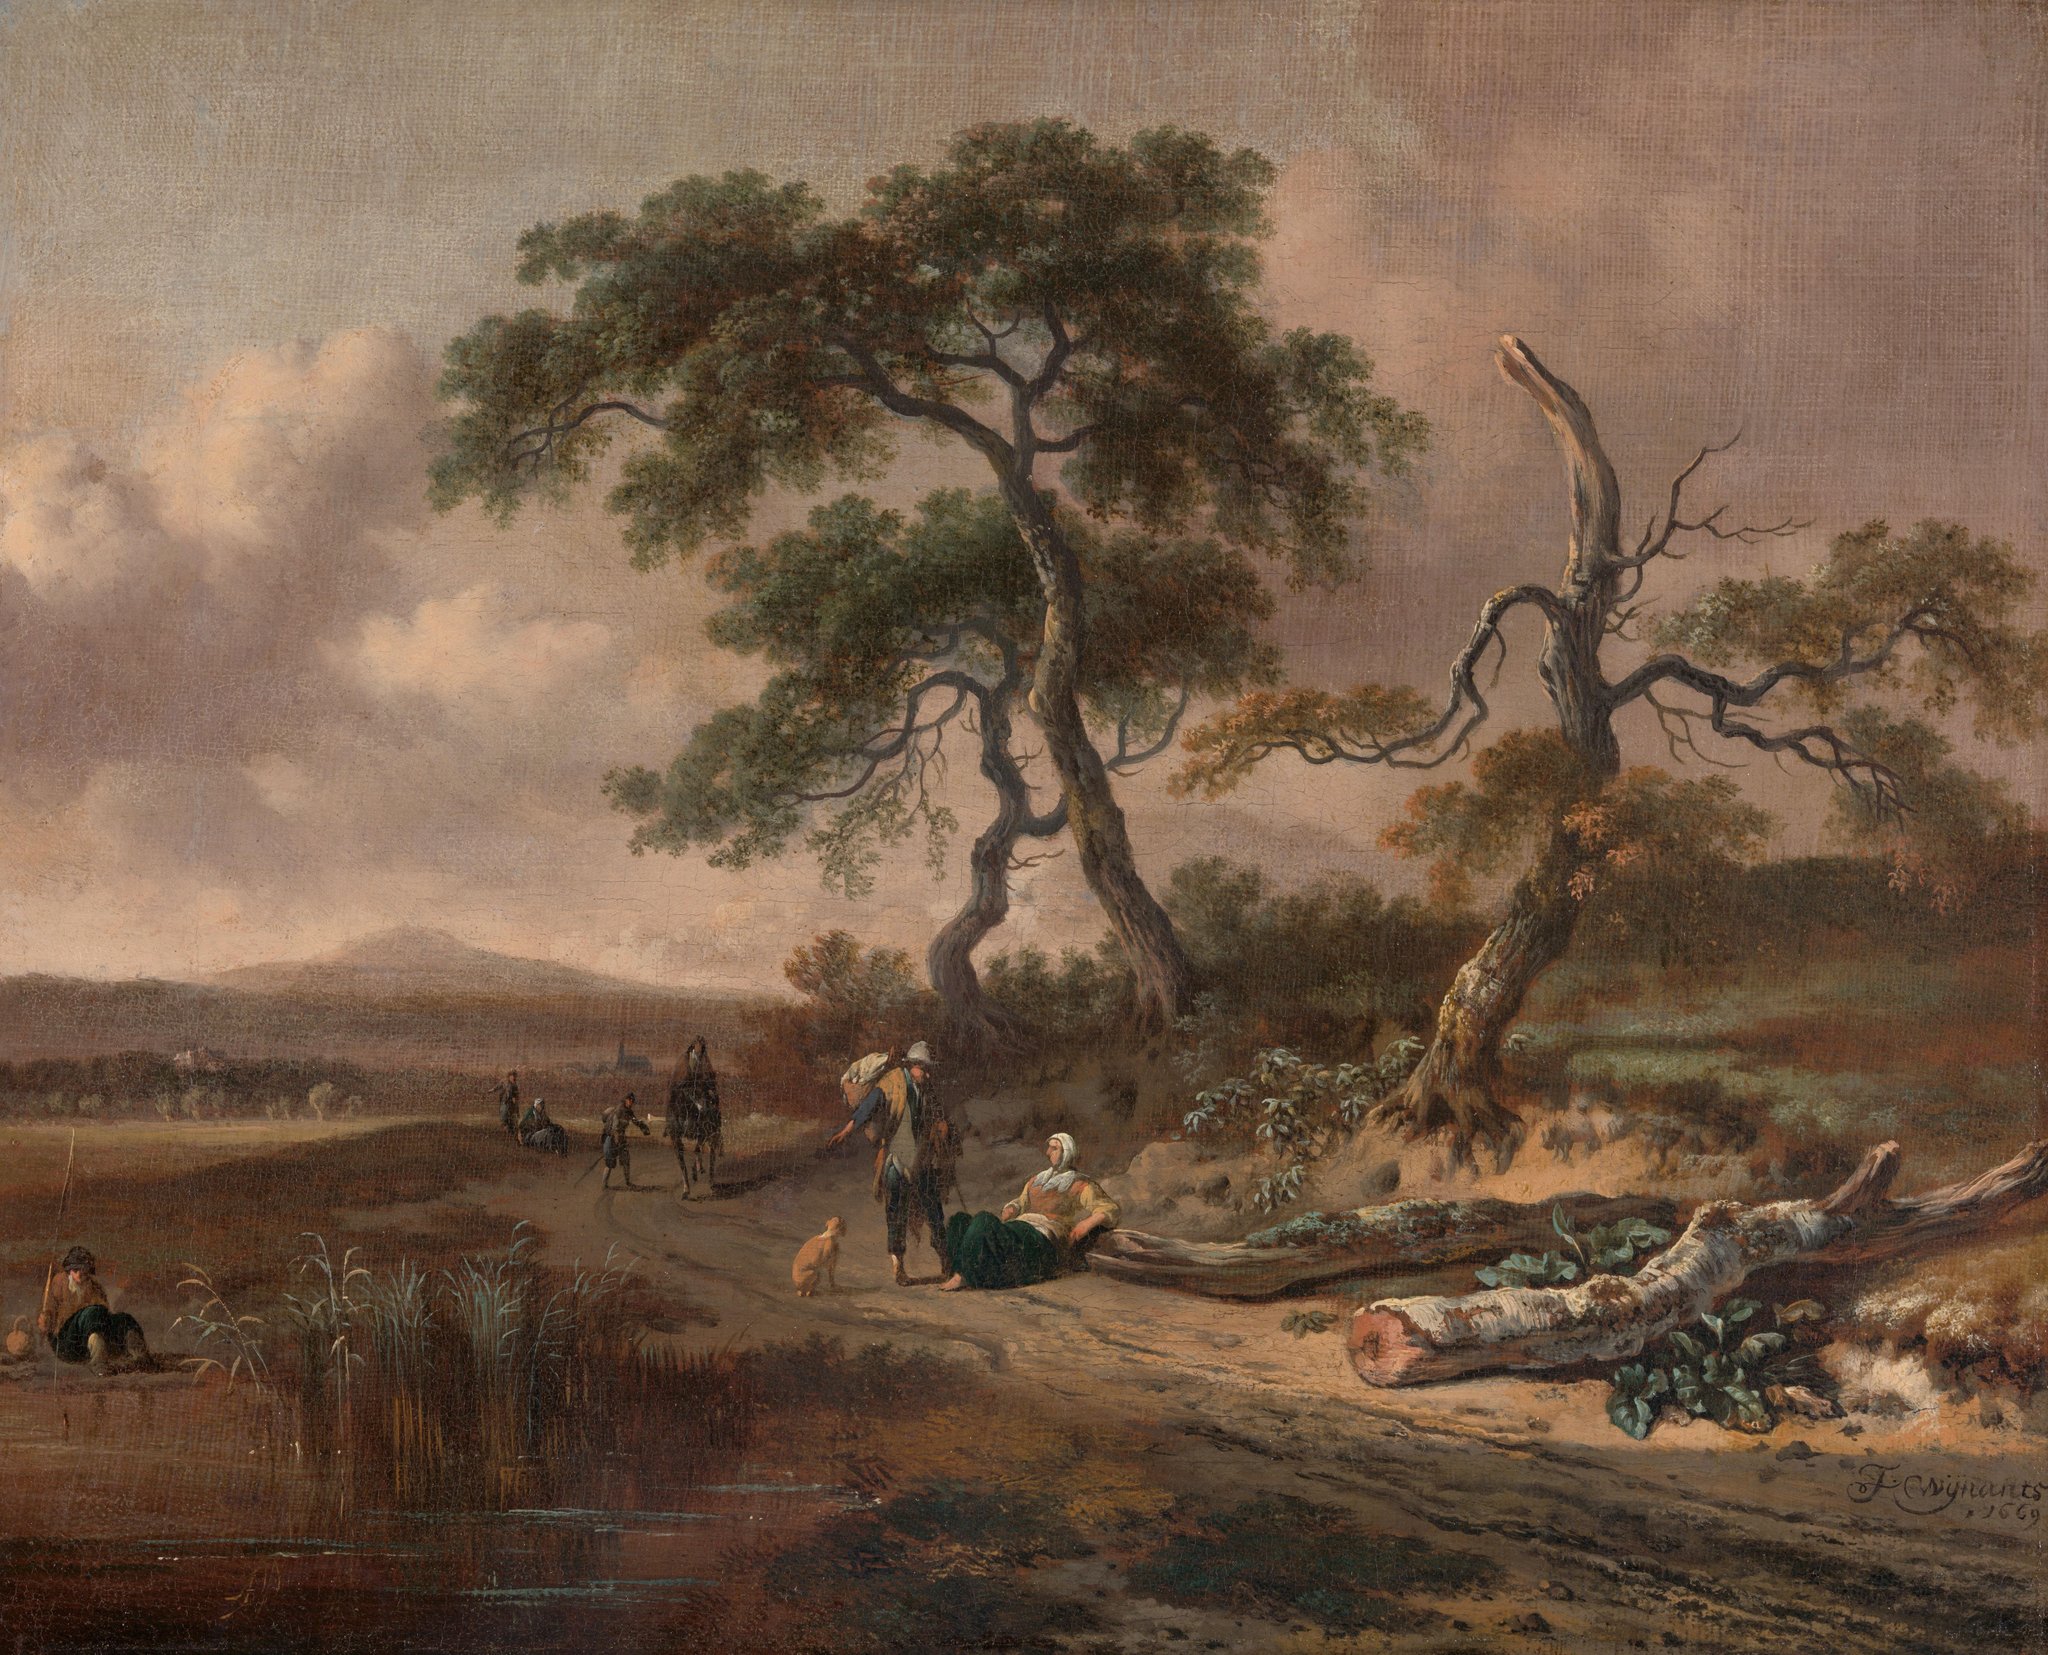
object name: painting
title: Landscape with a Peddler and Woman Resting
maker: jan wijnants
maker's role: draughtsman, painter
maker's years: 1632-1684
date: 1669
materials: canvas, oil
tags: low hill country, pedlar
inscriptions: signature and date: ‘J. Wijnants 1669’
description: Landschap met een marskramer die een praatje maakt met een rustende vrouw die bij boomstammen naast de weg ligt. Meer naar achteren komen andere figuren over de weg. Links een vissende man met een hengel.